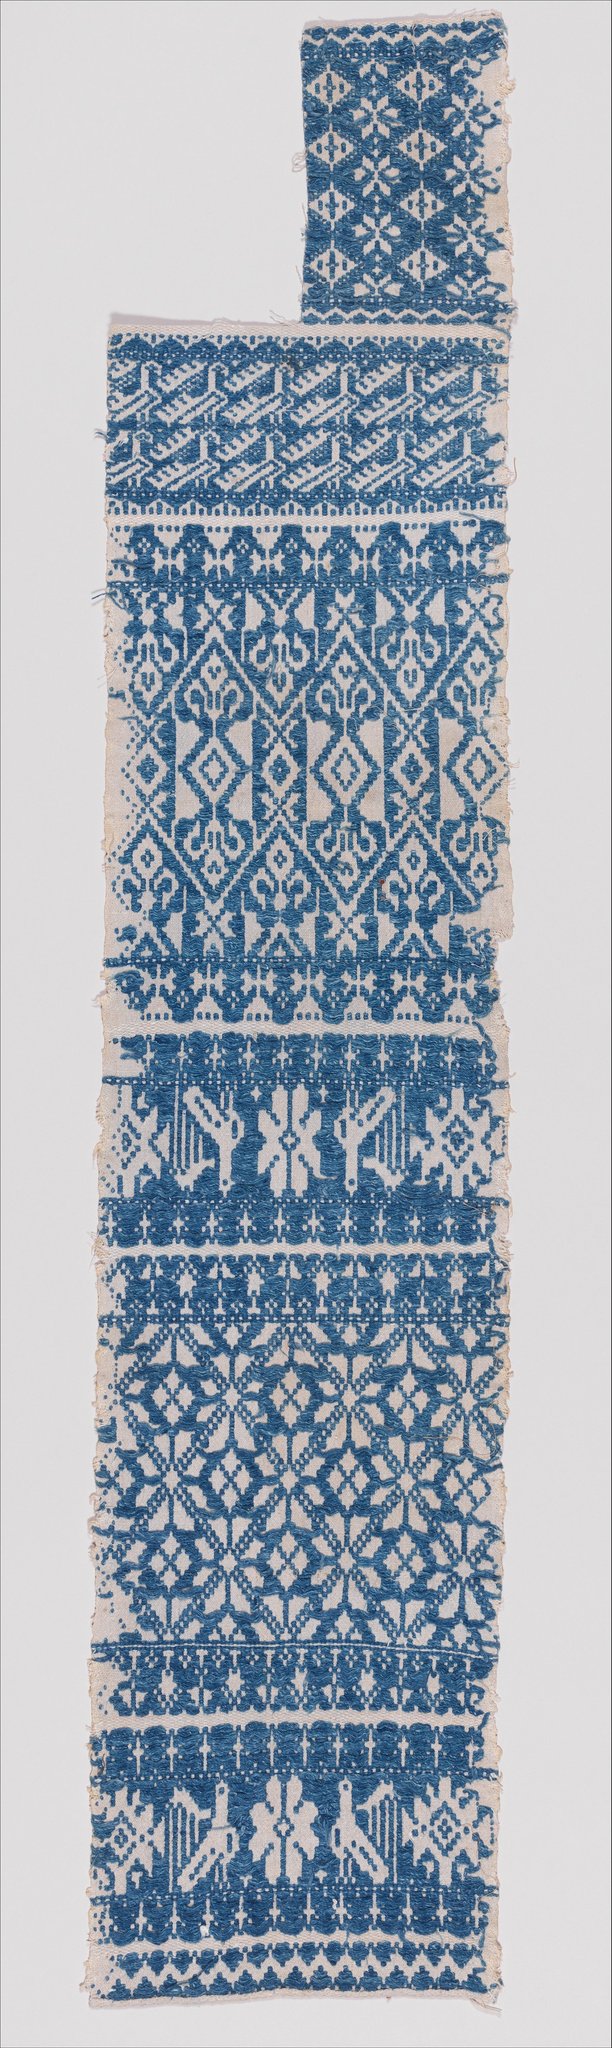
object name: piece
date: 1501-1600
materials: linen